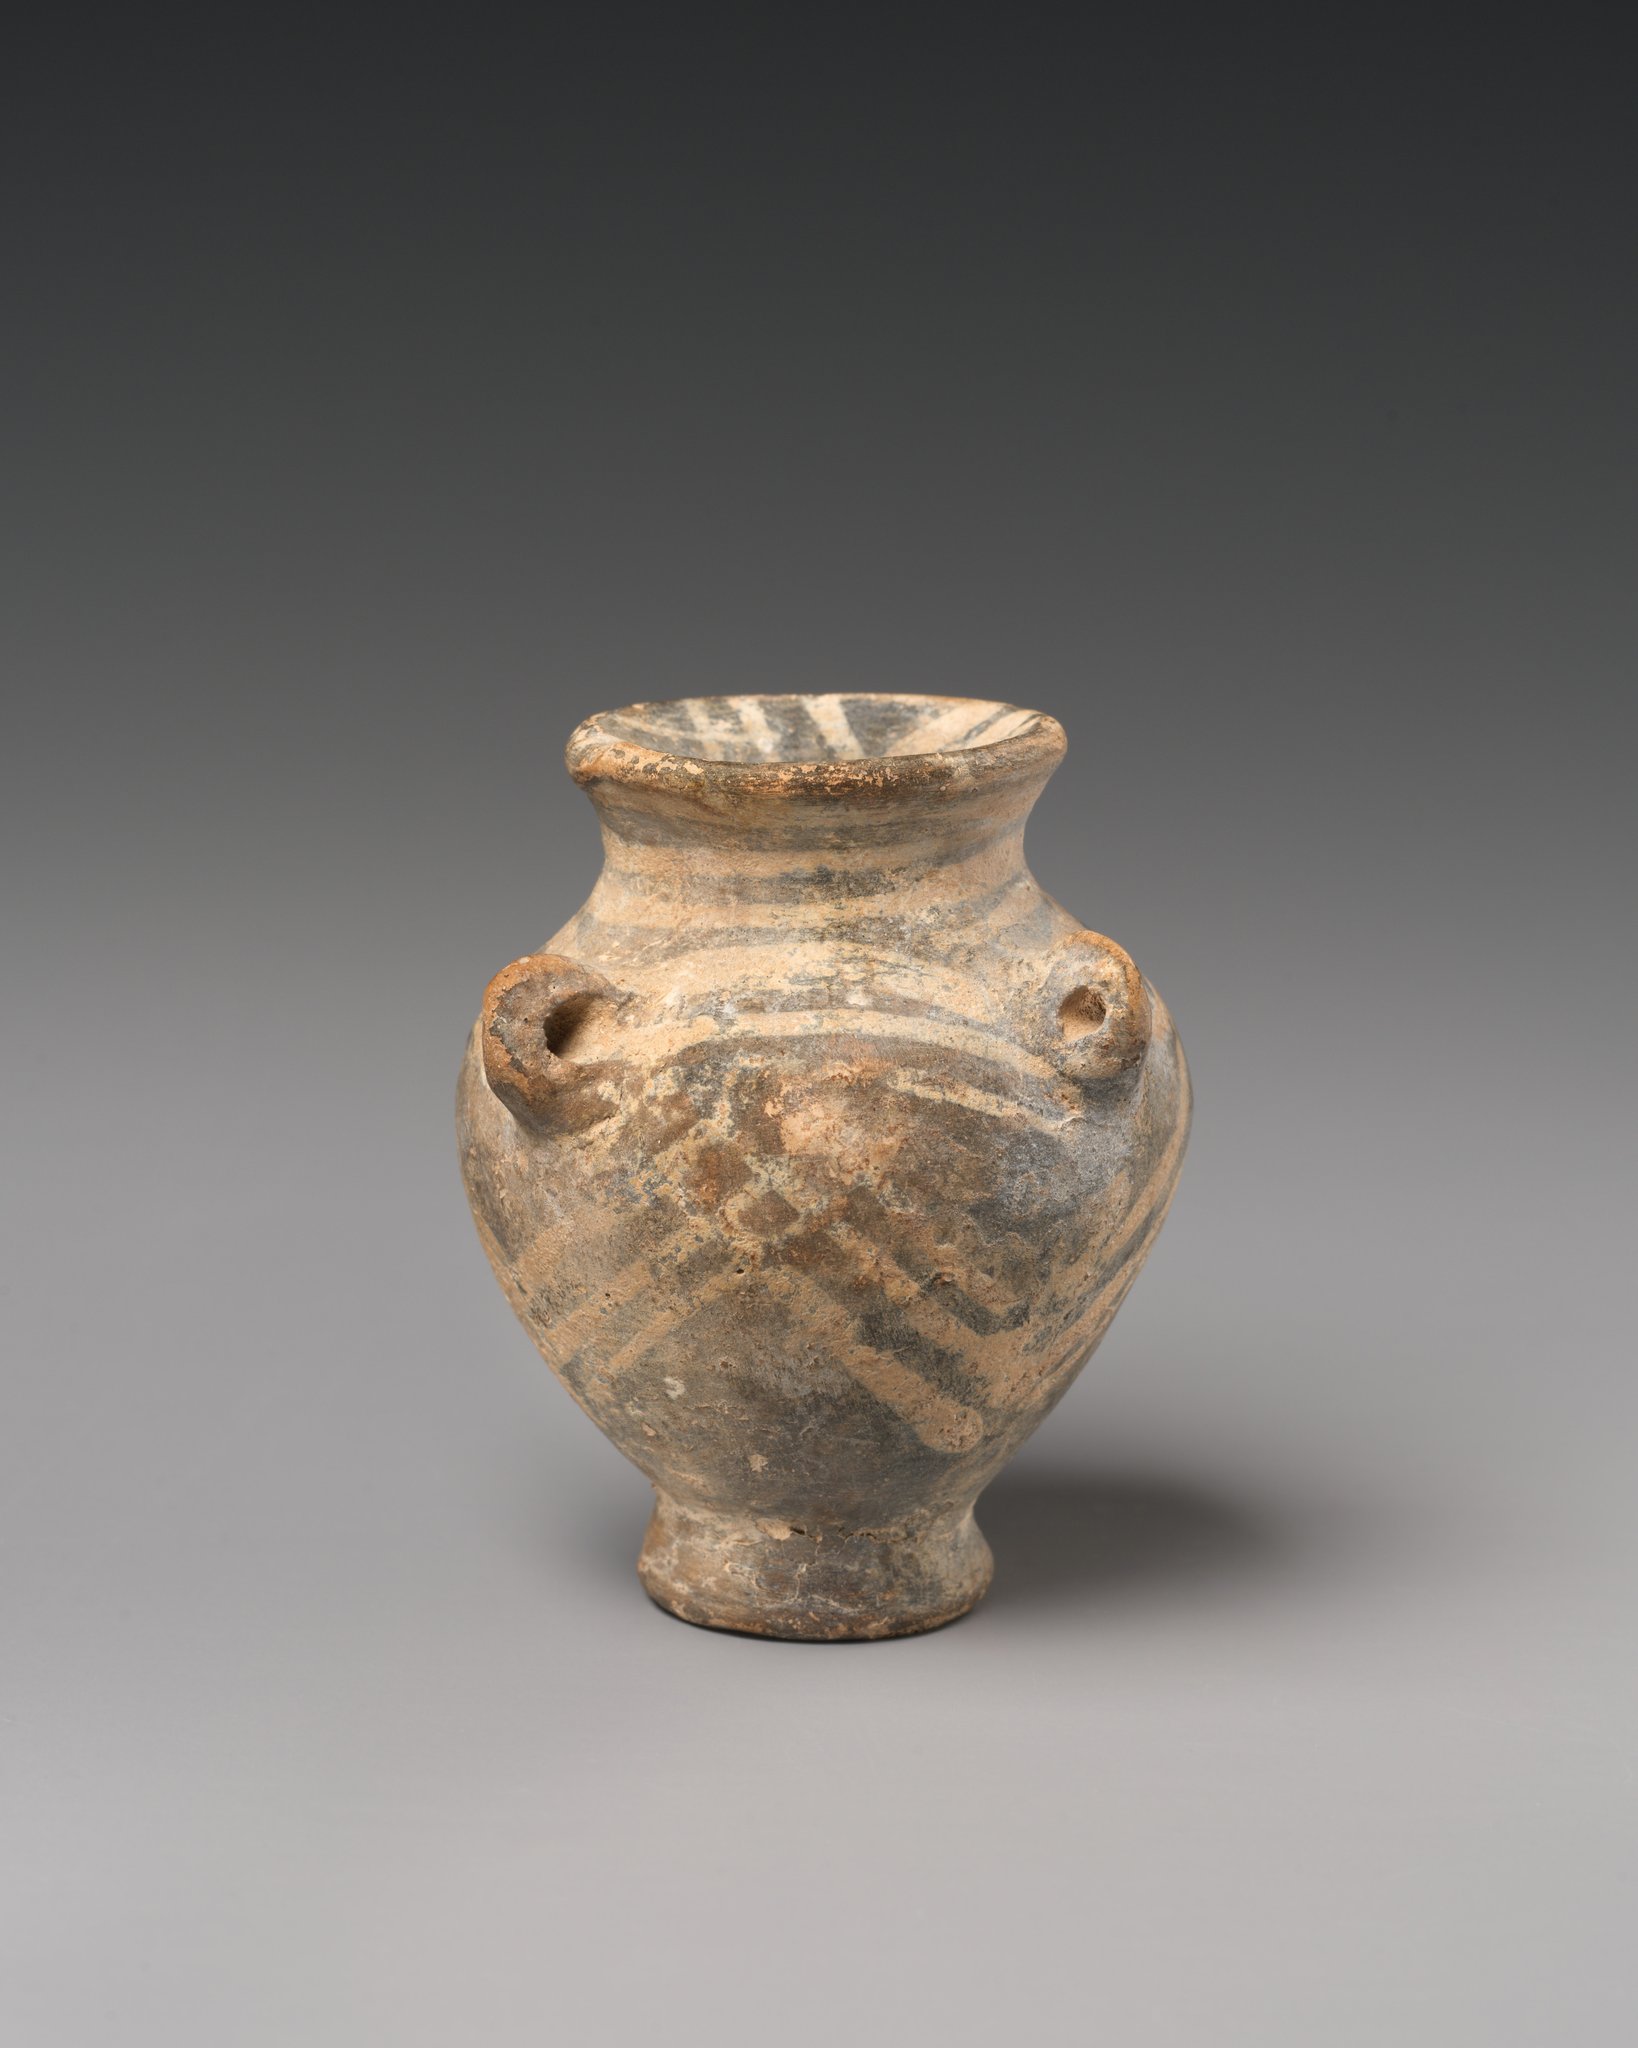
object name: jar, miniature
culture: cypriot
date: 1600-1050 BCE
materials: terracotta